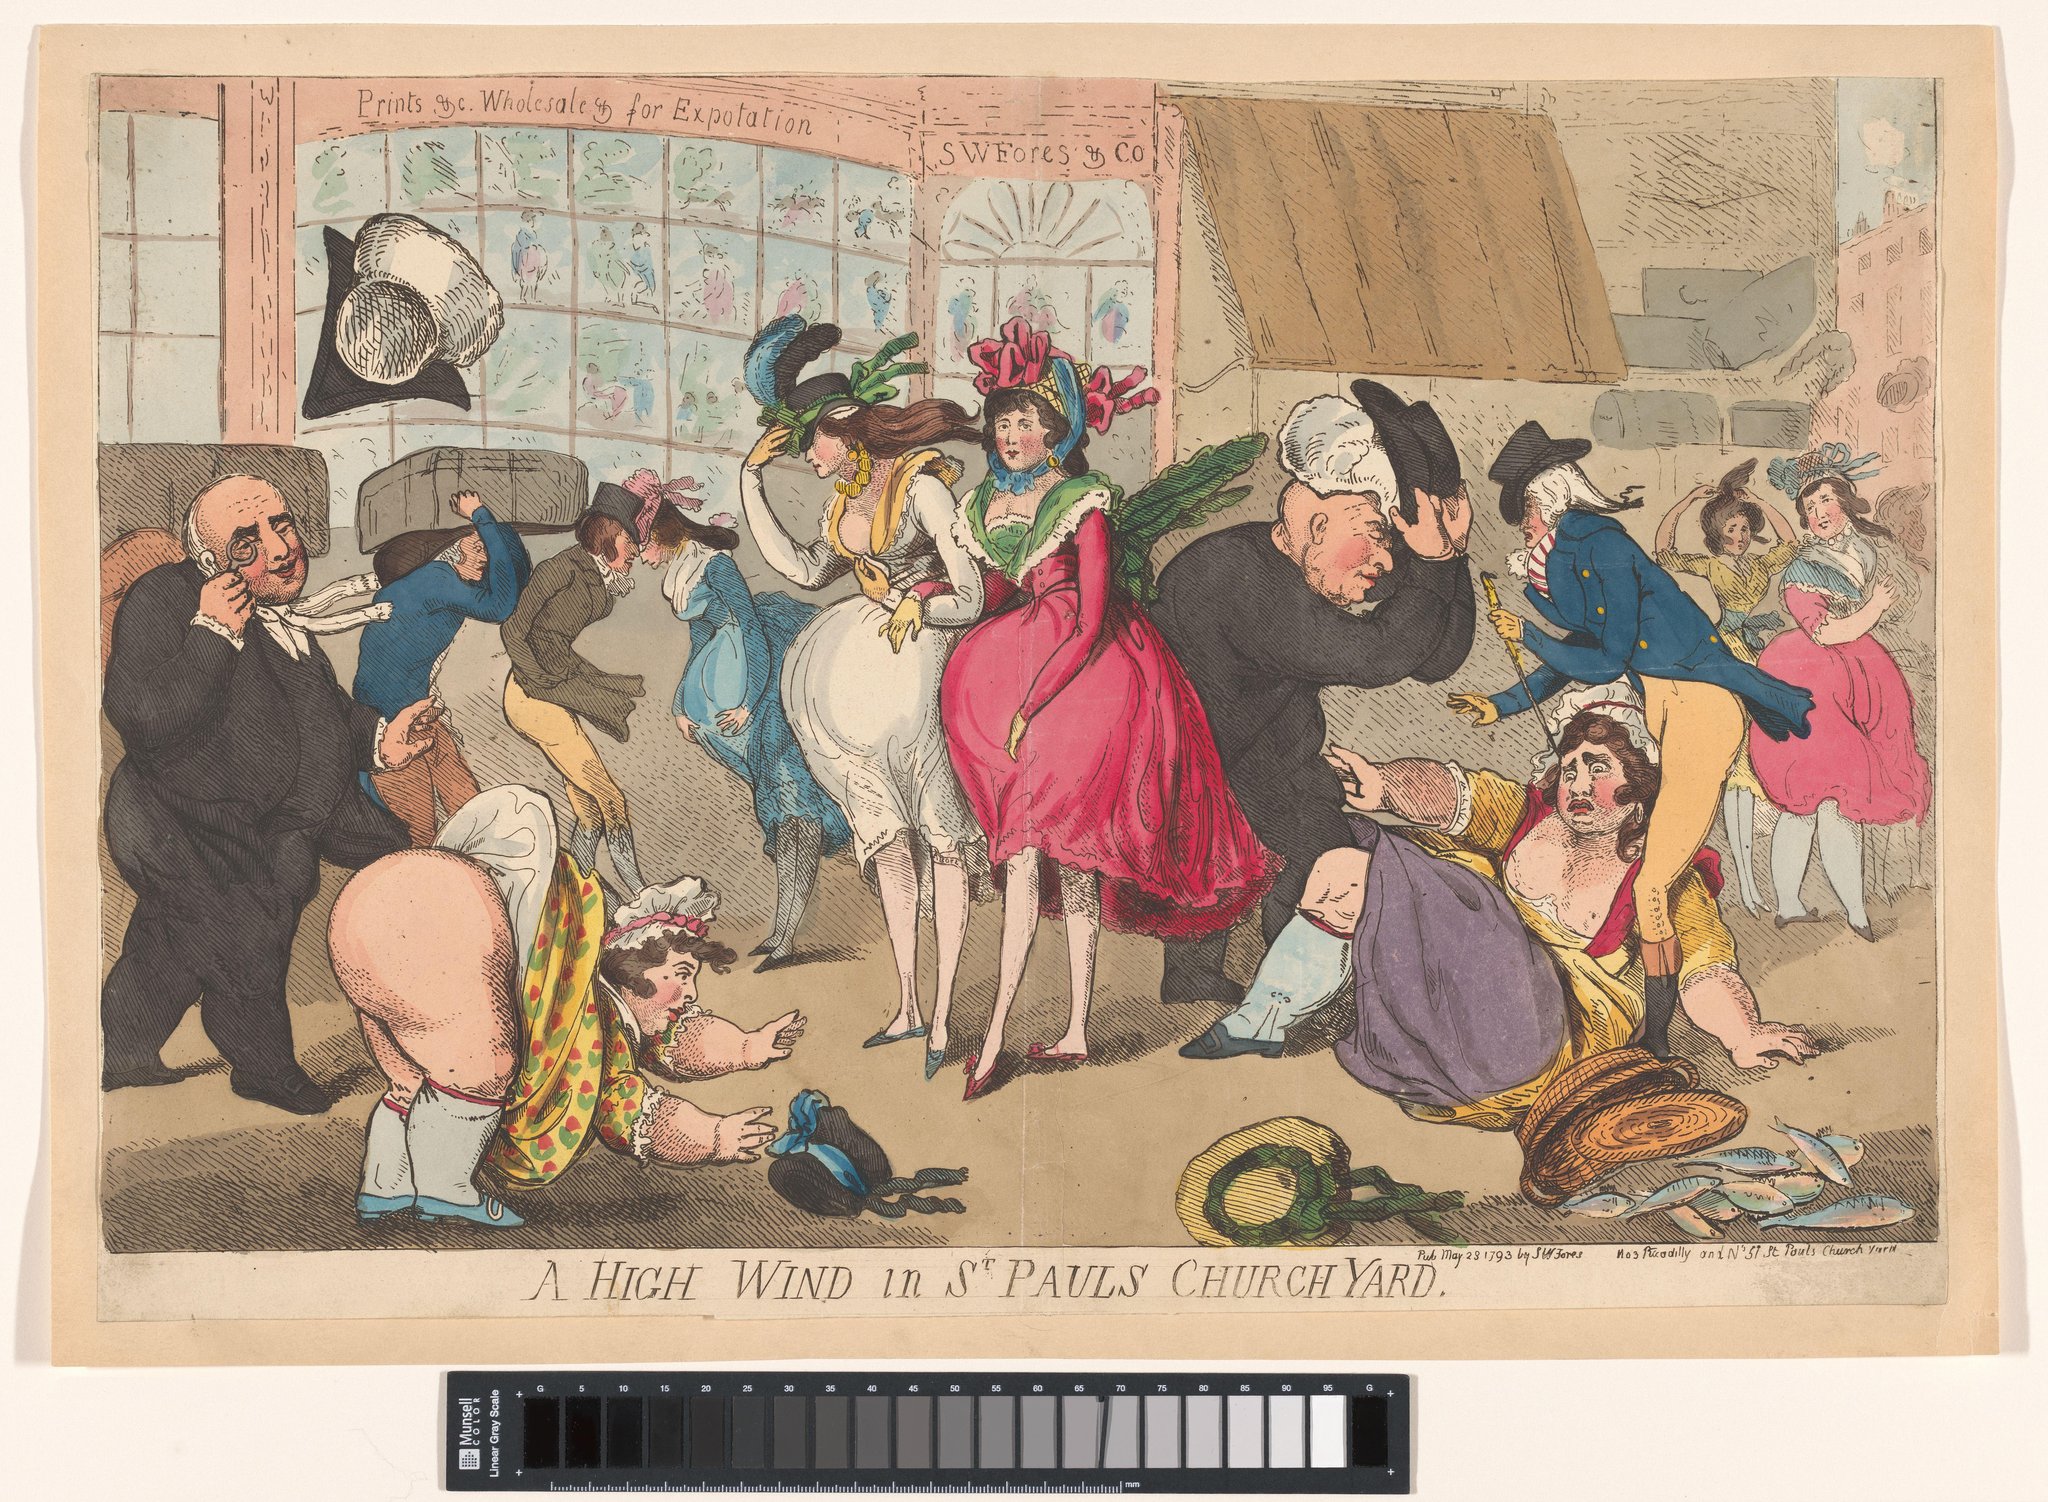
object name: print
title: Voorbijgangers verrast door een windvlaag voor de etalage van Samuel W. Fores te Londen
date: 1793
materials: paper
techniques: etching, hand coloring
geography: london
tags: art dealer (+ graphic arts), storm on land, political caricatures and satires, shop-window, show-window, london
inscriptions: collector's mark: Lugt 4779, collector's mark: Lugt 4780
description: Een windvlaag zorgt er voor dat alle voorbijgangers naar hun hoed grijpen. Links bukt een vrouw naar haar hoed waardoor haar jurk omhoog waait en haar billen te zien zijn. Dit tafereel wordt gadegeslagen door een dominee met een vergrootglas. Rechts is een vrouw met een mand met vis gevallen. In de achtergrond de etalage van Samuel W. Fores vol met prenten.